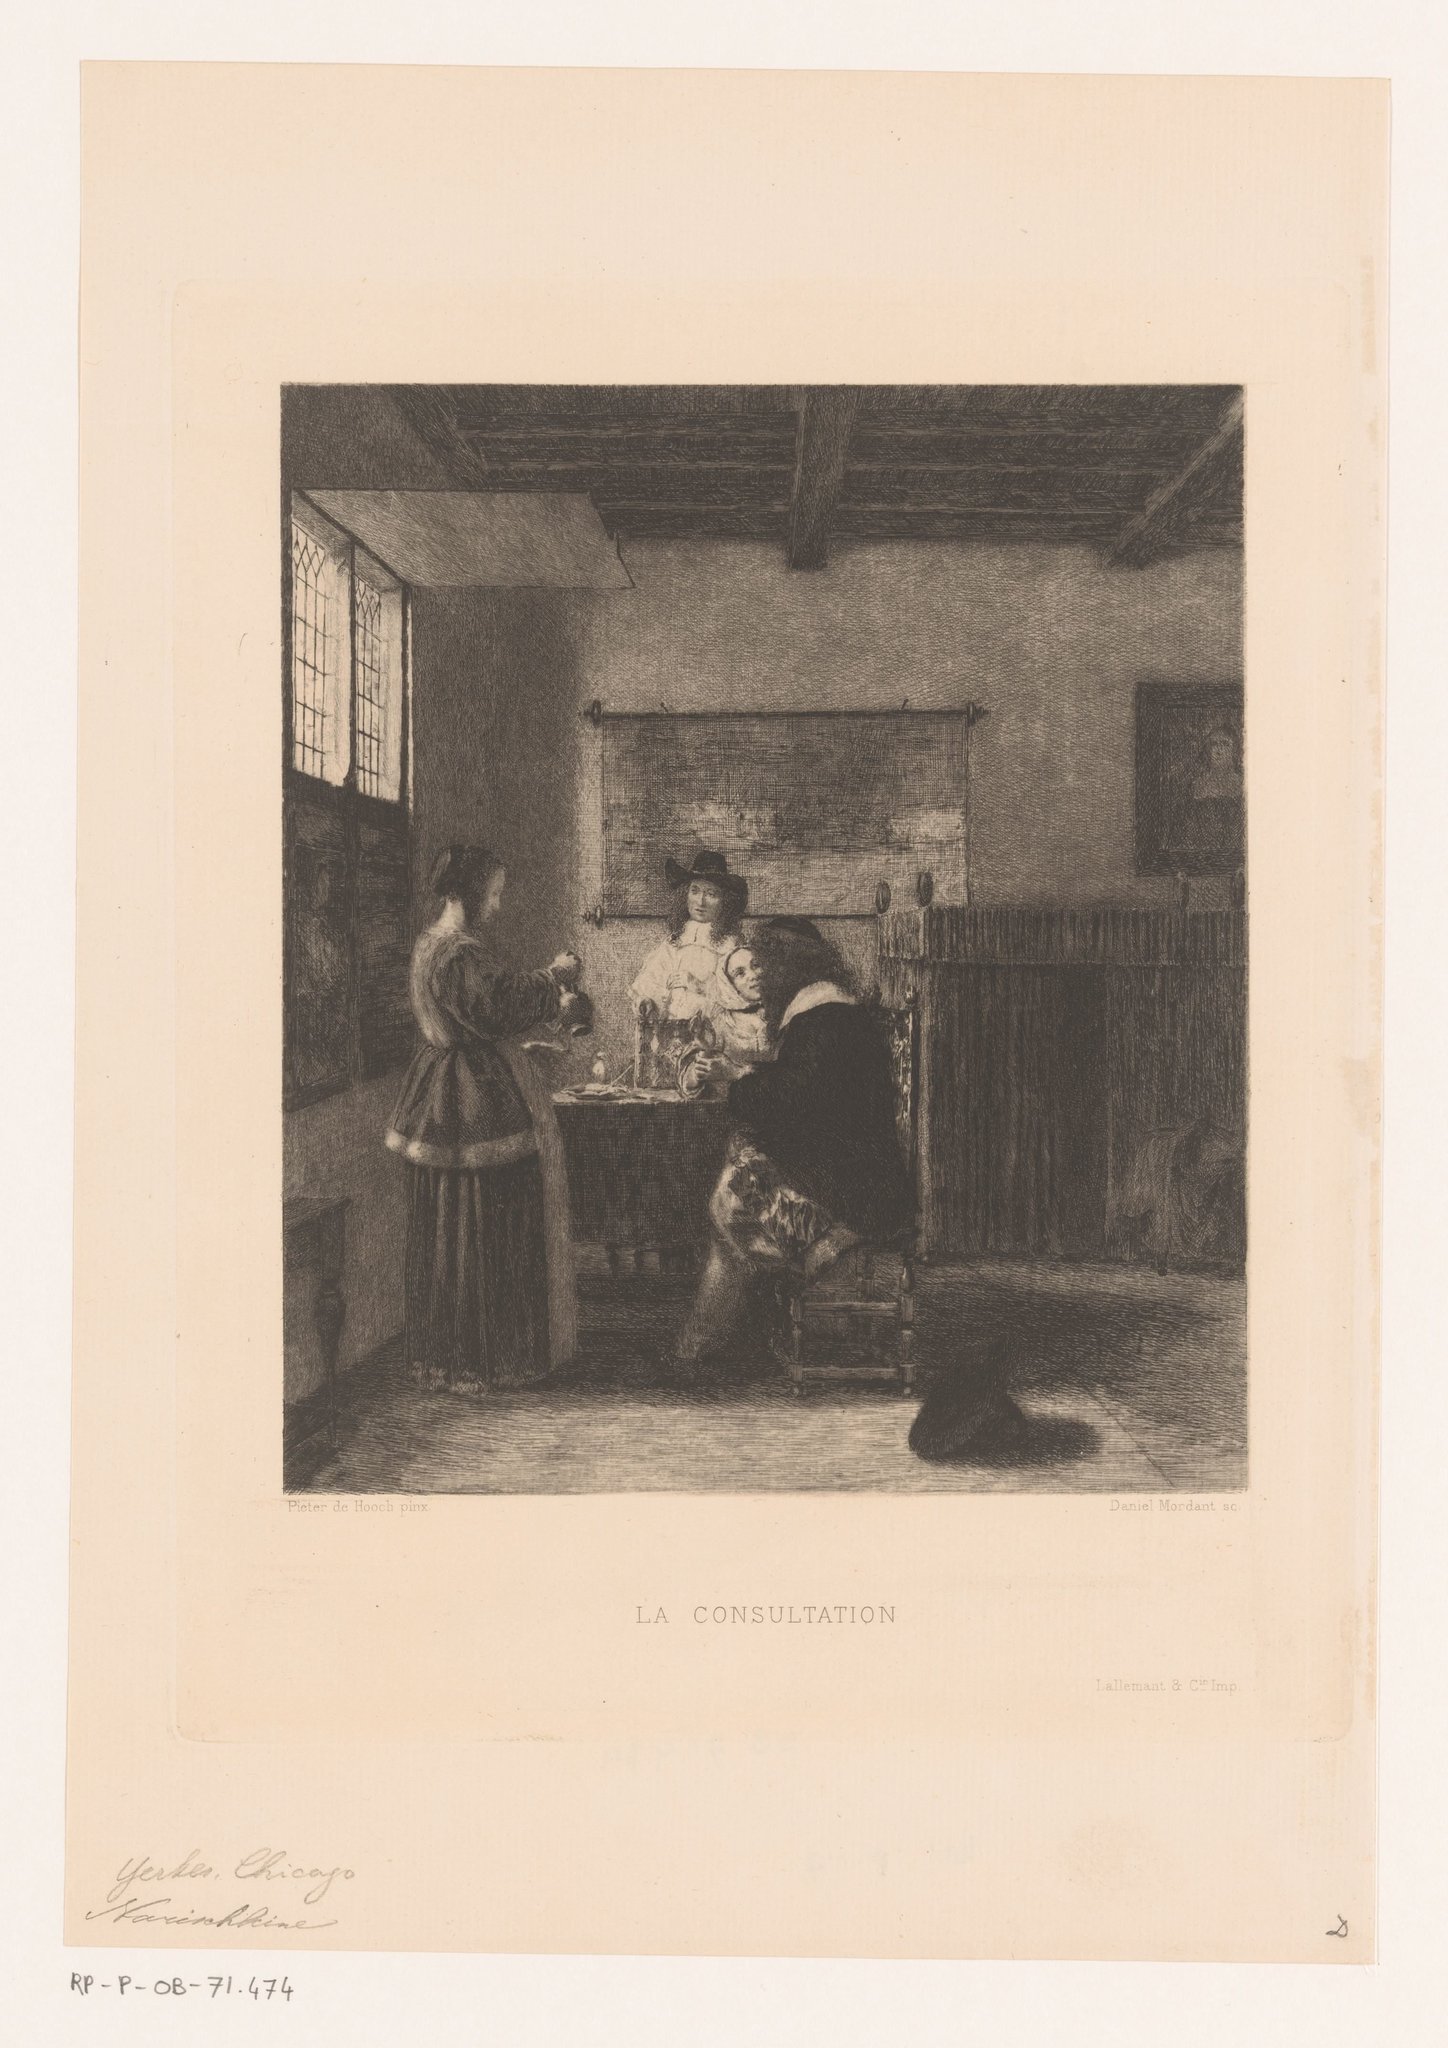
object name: print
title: Gezelschap met twee mannen en twee vrouwen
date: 1863-1914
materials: paper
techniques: etching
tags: visiting; receiving guests; elegant company, interior of the house, bed, picture, painting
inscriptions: inscription: ‘Yerkes, Chicago/ Narischkine’, collector's mark: Lugt 2228